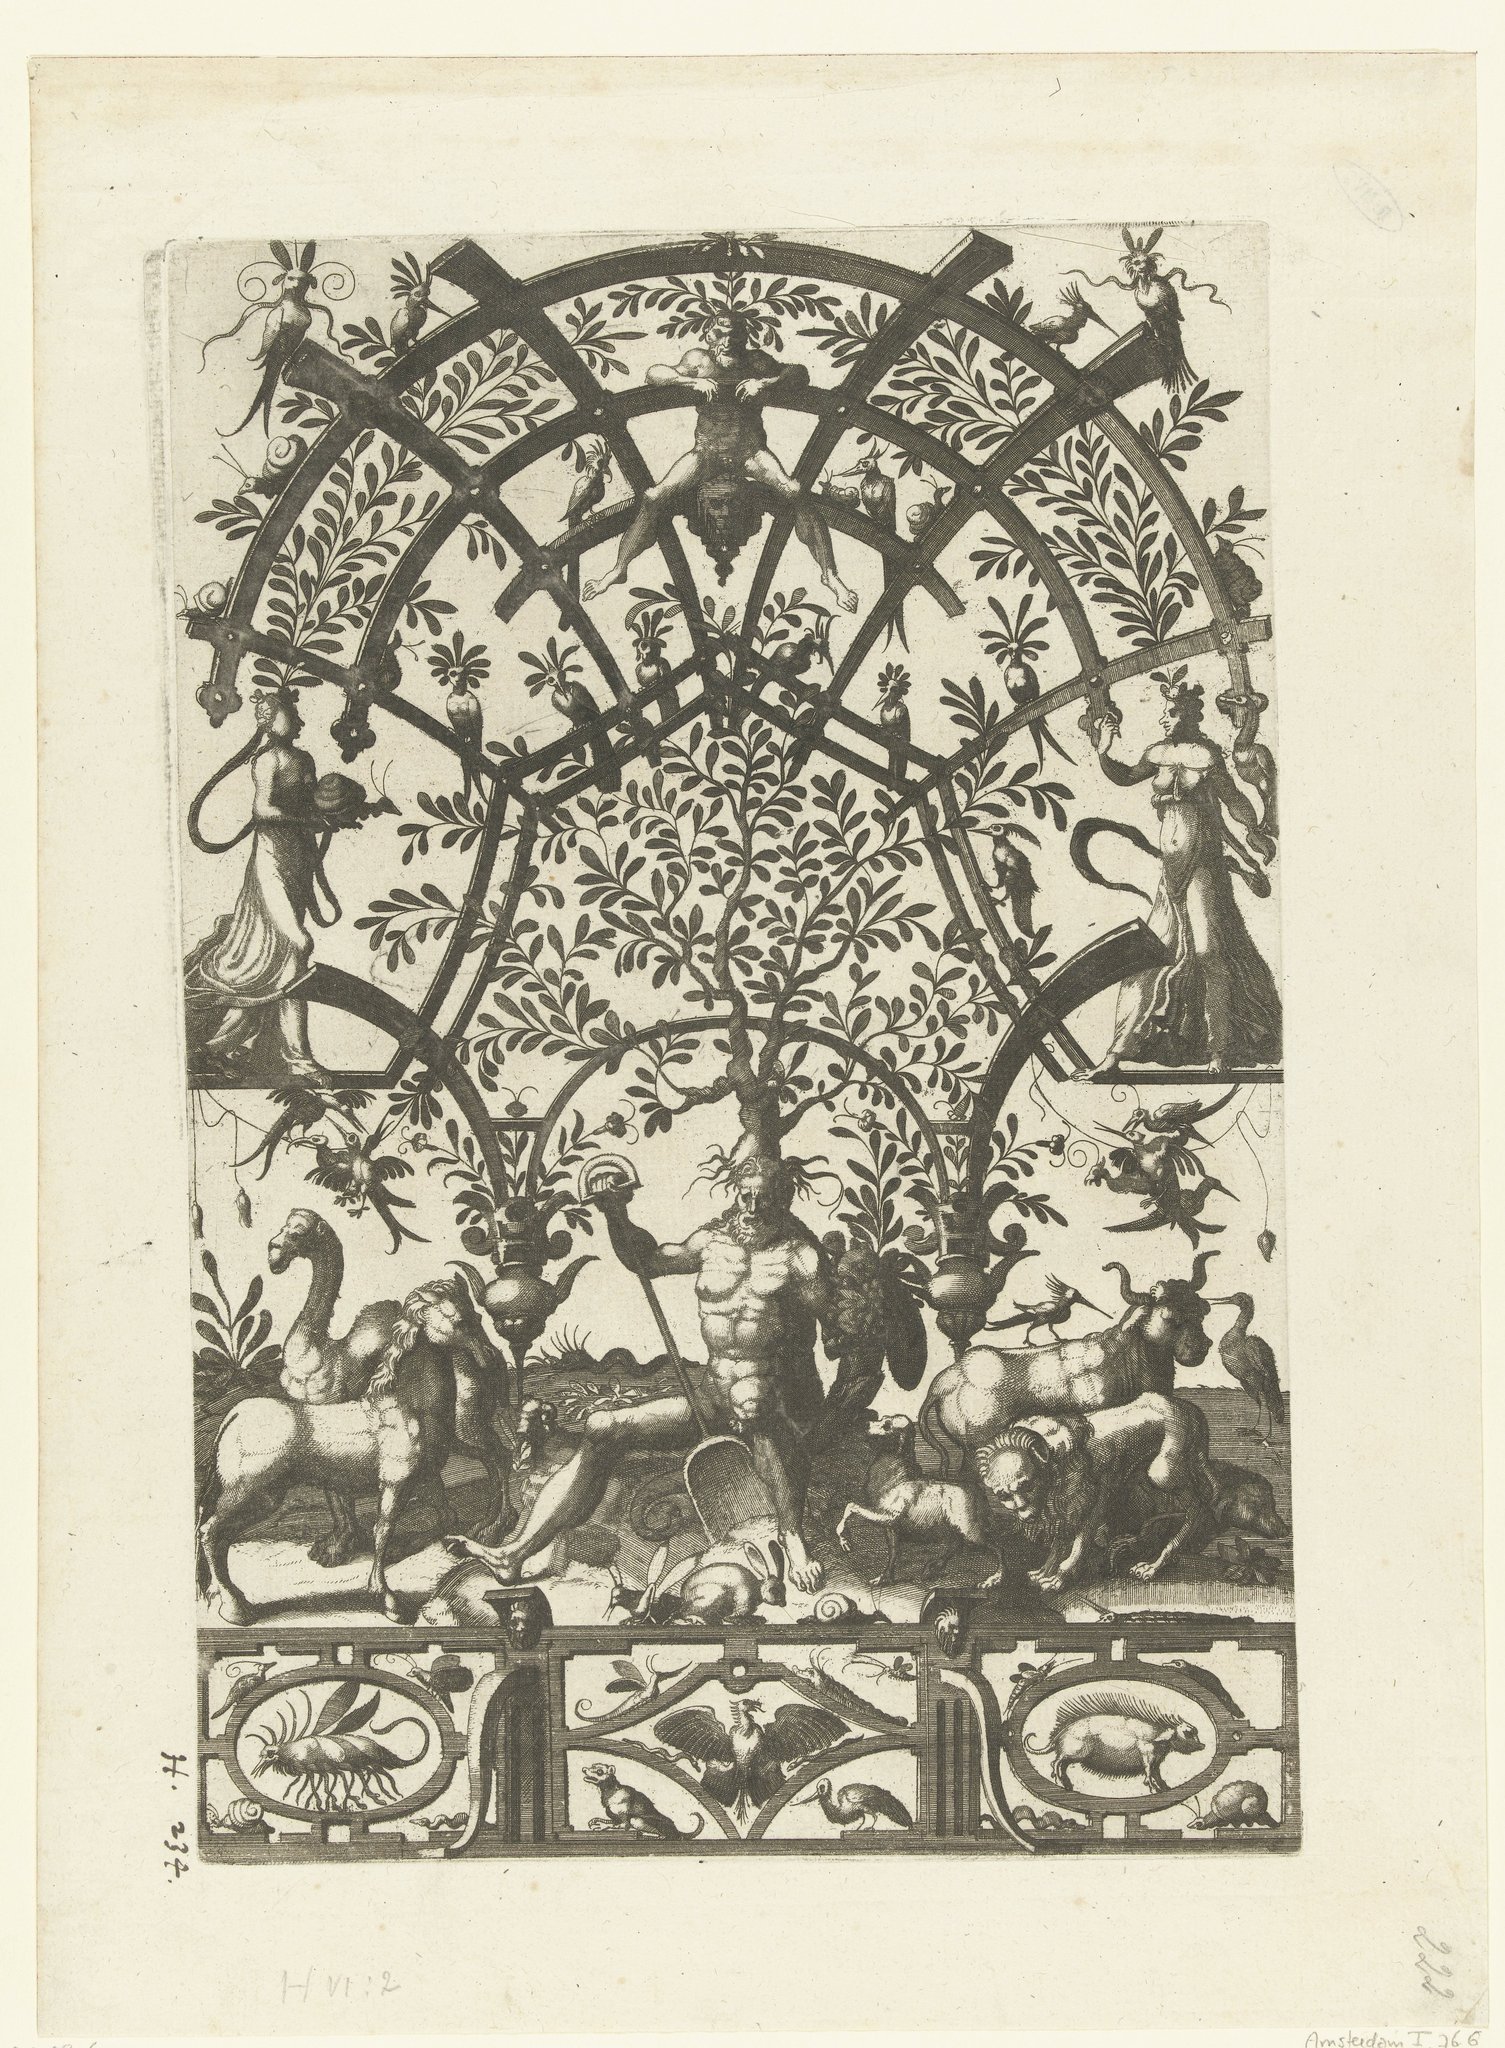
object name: ornament print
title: Vlakdecoraties en grafmonumenten / Veelderleij niewe inventien (...)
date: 1557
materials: paper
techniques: etching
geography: netherlands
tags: 'cornucopia', horn of plenty, animals, scrollwork, strapwork ~ ornament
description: Op een basement, bestaande uit een driedelig fries met rolwerk en dieren, zit een man met een schop en hoorn des overvloeds. Uit zijn hoofd groeit een boom. Links van hem staan een paard en een kameel; rechts een rund, hond en leeuw. Hoort bij serie bestaande uit een titelblad, een tekstblad en 14 bladen met grotesken met rolwerk, saters, guirlandes, trofeeën, dieren en fantasiewezens.